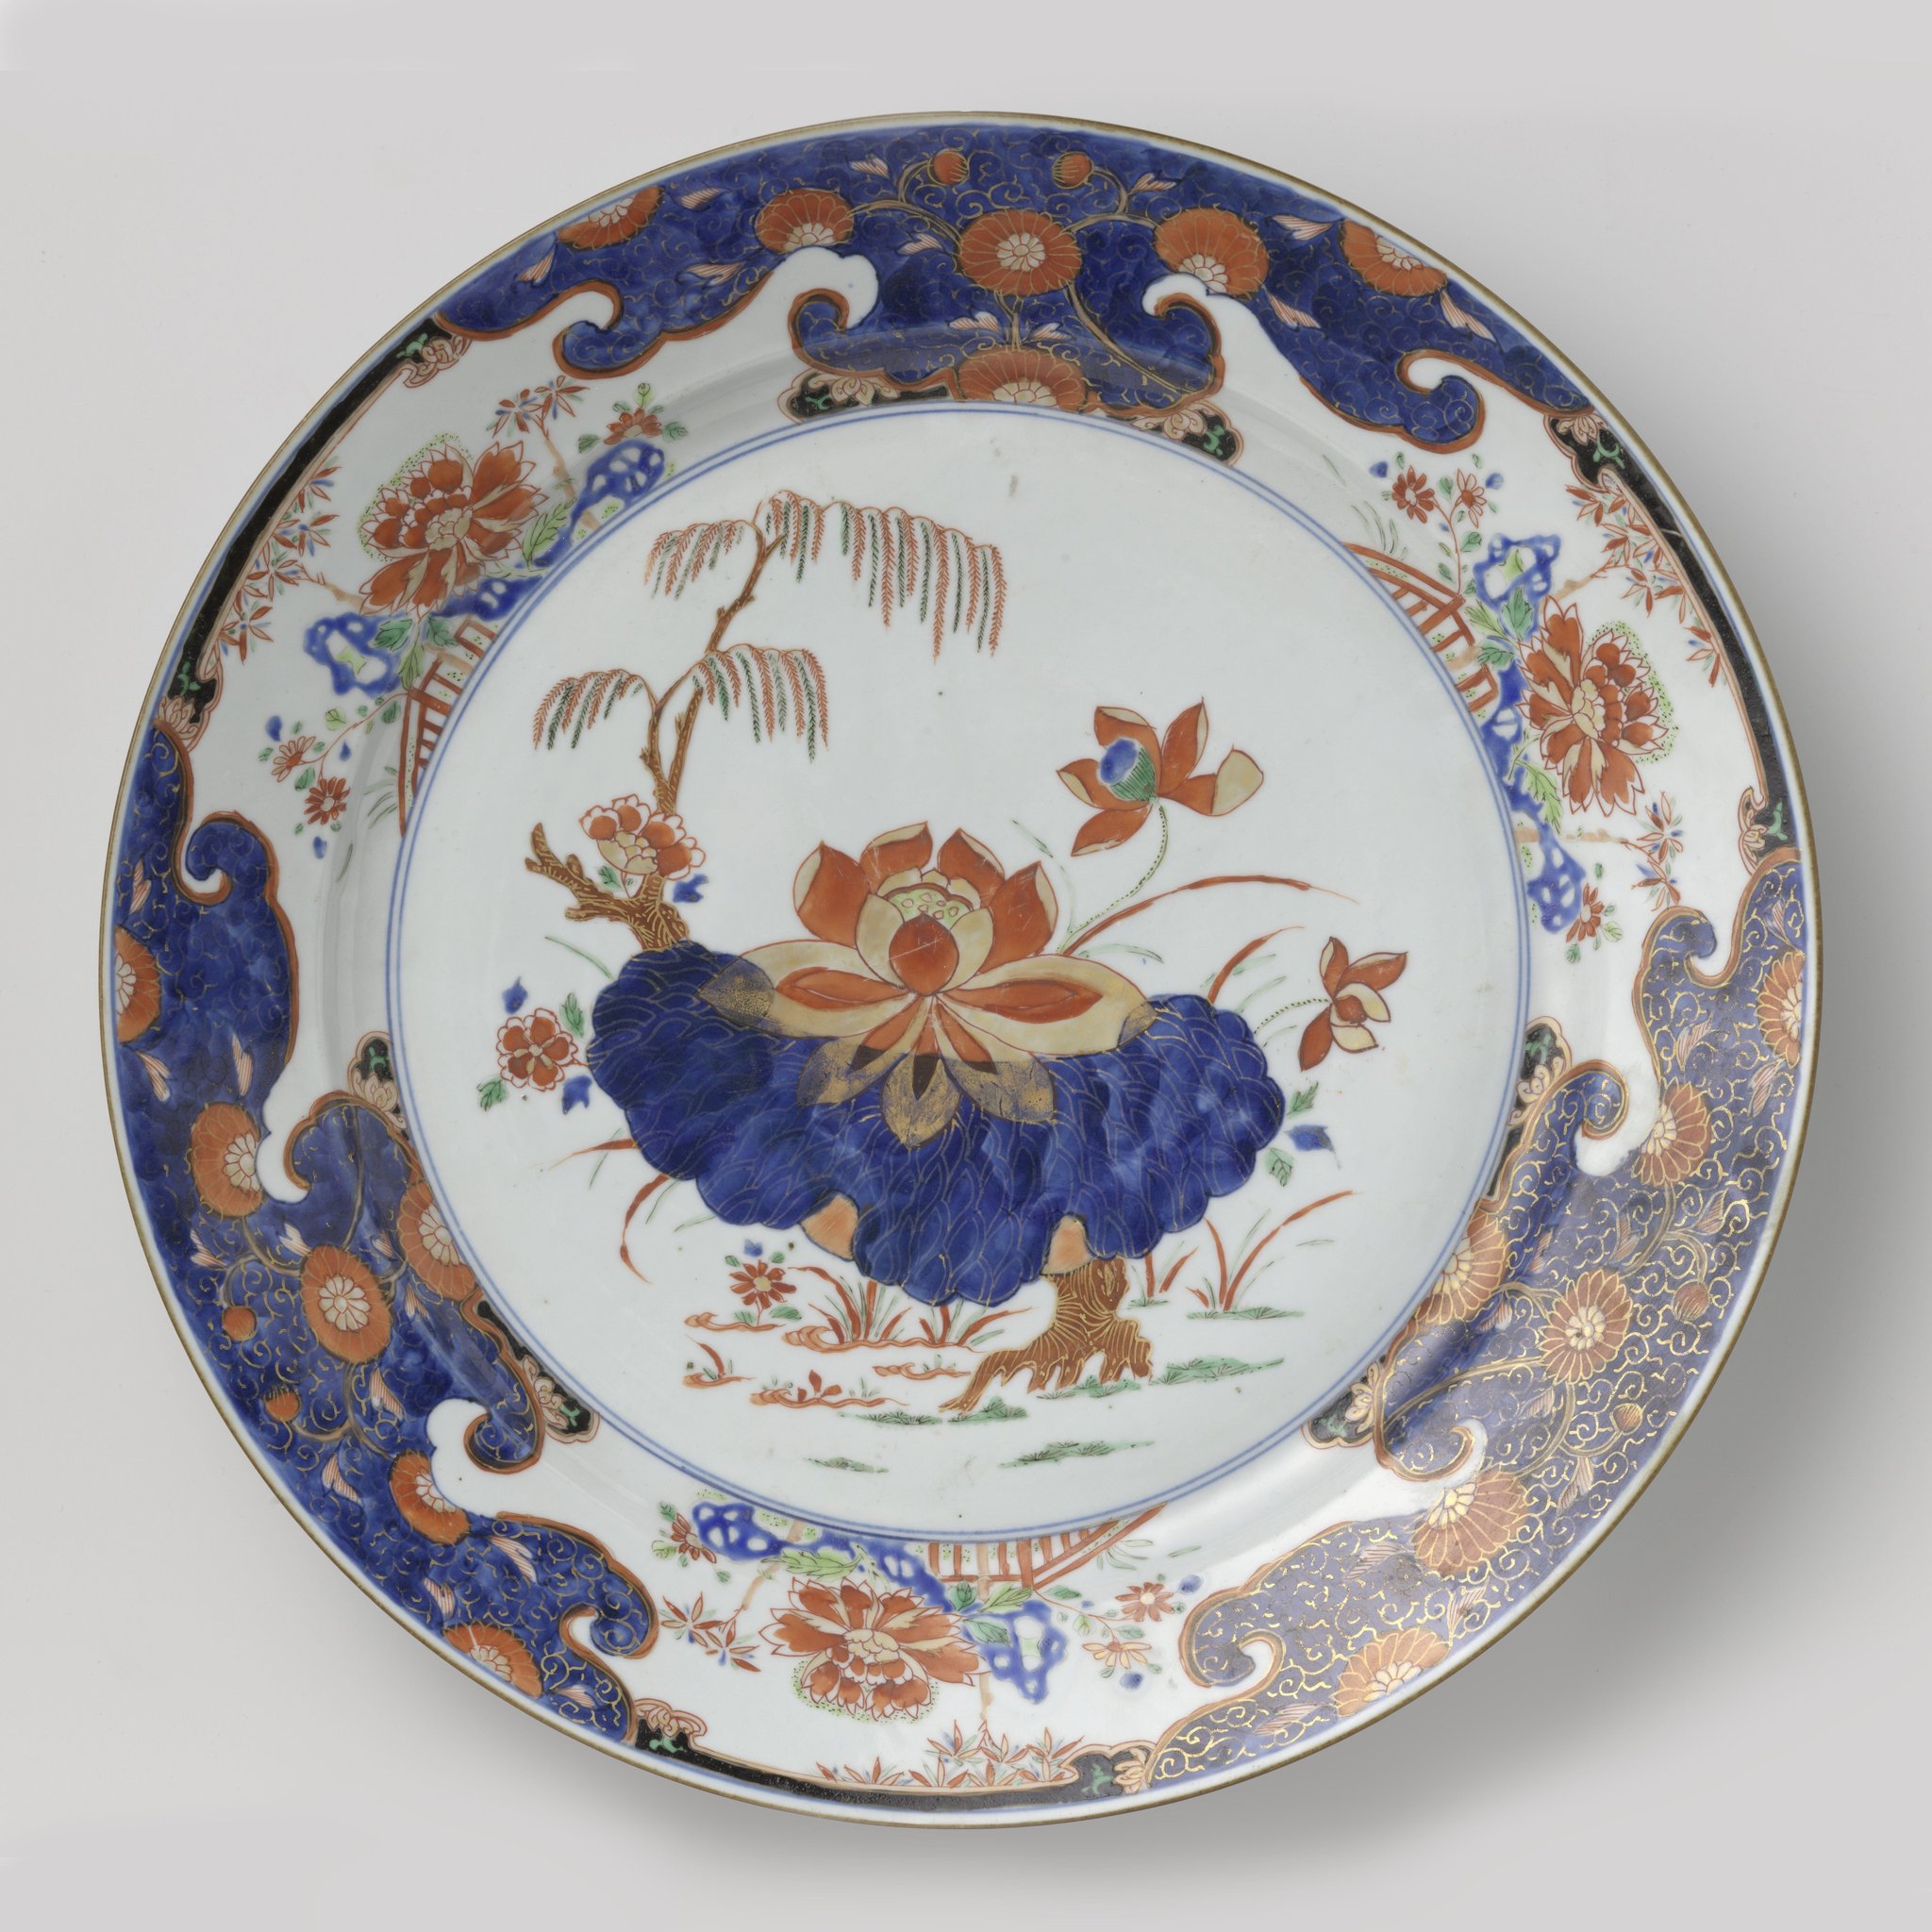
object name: platter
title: Dish with large lotus, weeping willow and plants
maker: Anonymous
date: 1800-1899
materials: cobalt, glaze, gold, paint, porcelain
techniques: firing, gilding, turning, vitrification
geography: china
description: Schotel van porselein, Imari. In het plat een grondje met takken en bloemen. Op de rand drie grote onregelmatige blauwe vakken met rode margrieten en gouden spiralen.